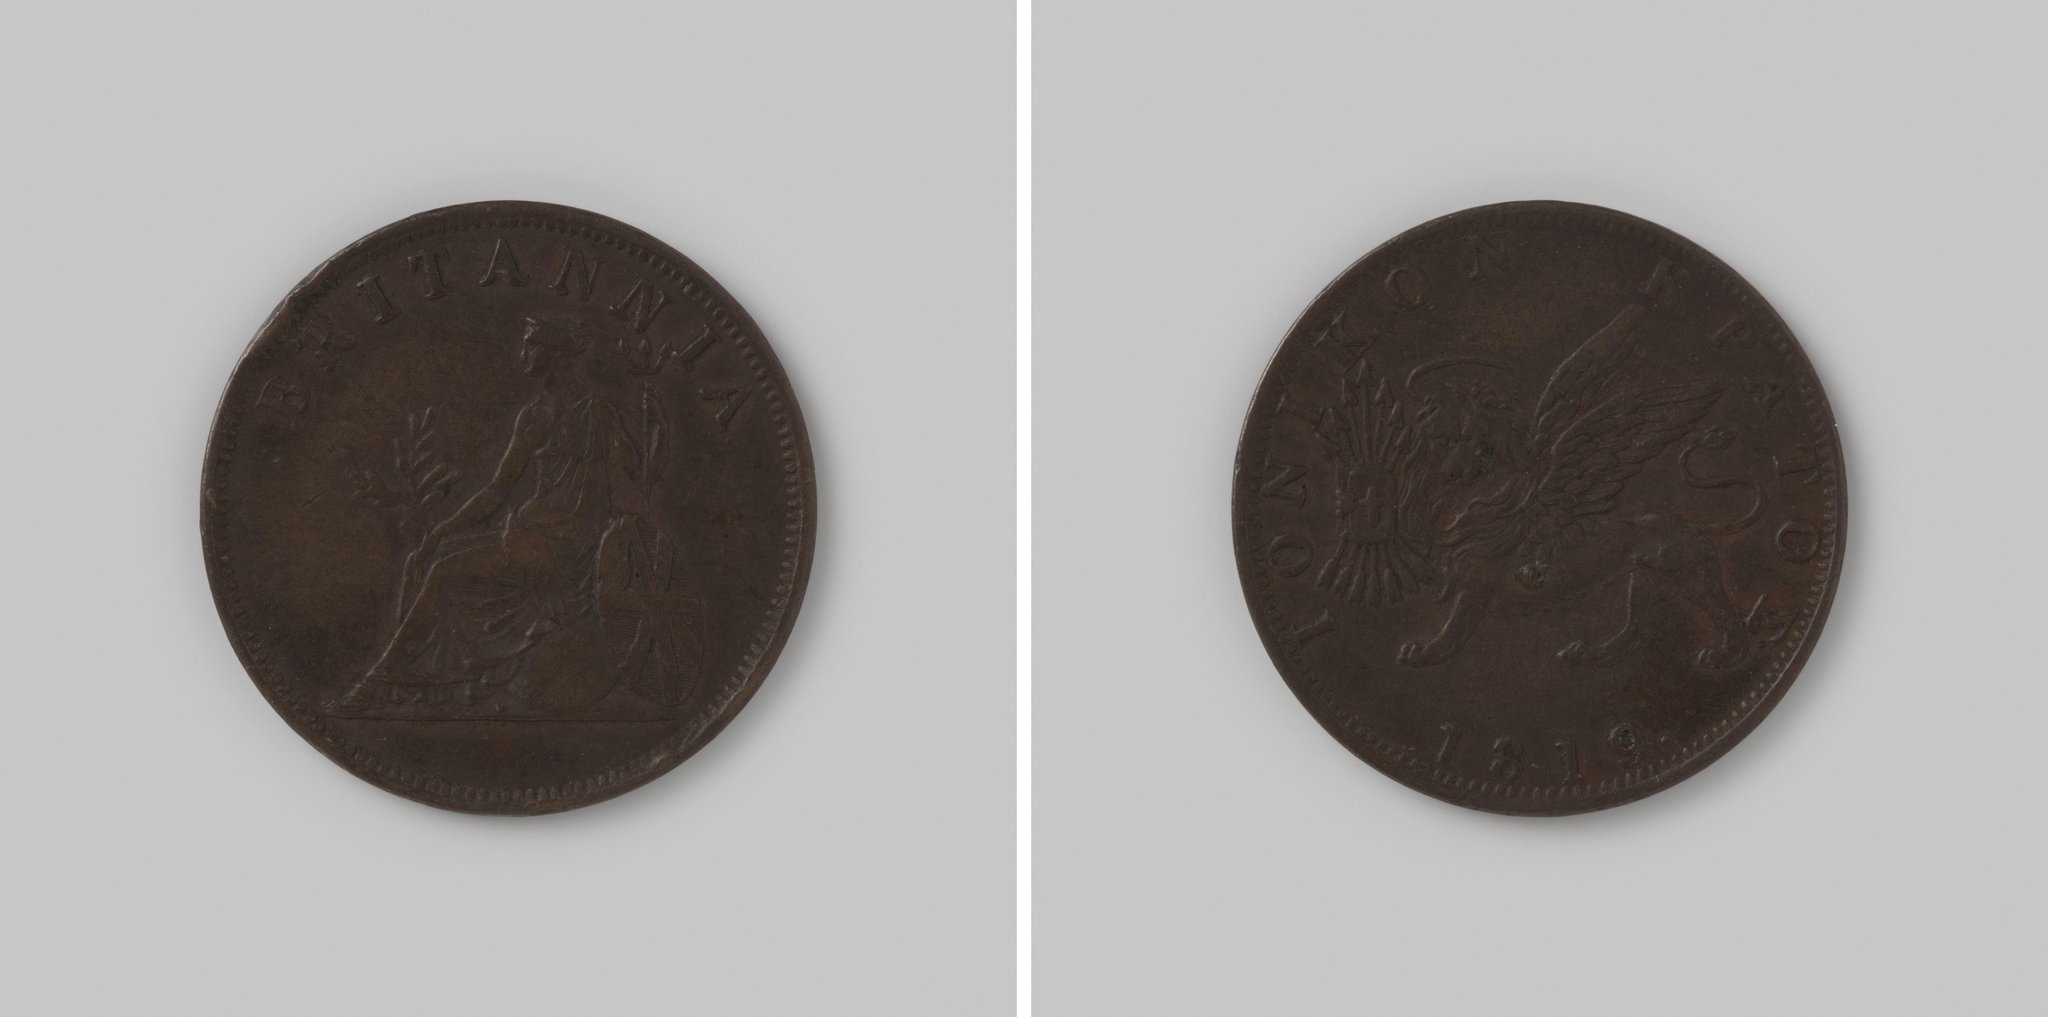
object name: coin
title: ½ penny of obool uit de Ionische eilanden onder heerschappij van Groot-Brittannië, 1819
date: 1819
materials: copper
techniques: striking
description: Koperen munt. Voorzijde: Brittannia naar links, gezeten op een rots, waartegen een schild, met in haar linkerhand een drietand en in haar rechter een tak. Keerzijde: gevleugelde leeuw met in zijn rechterpoot het evangelie, omgeven door een pijlenbundel. Jaartal onderaan. Gladde rand.